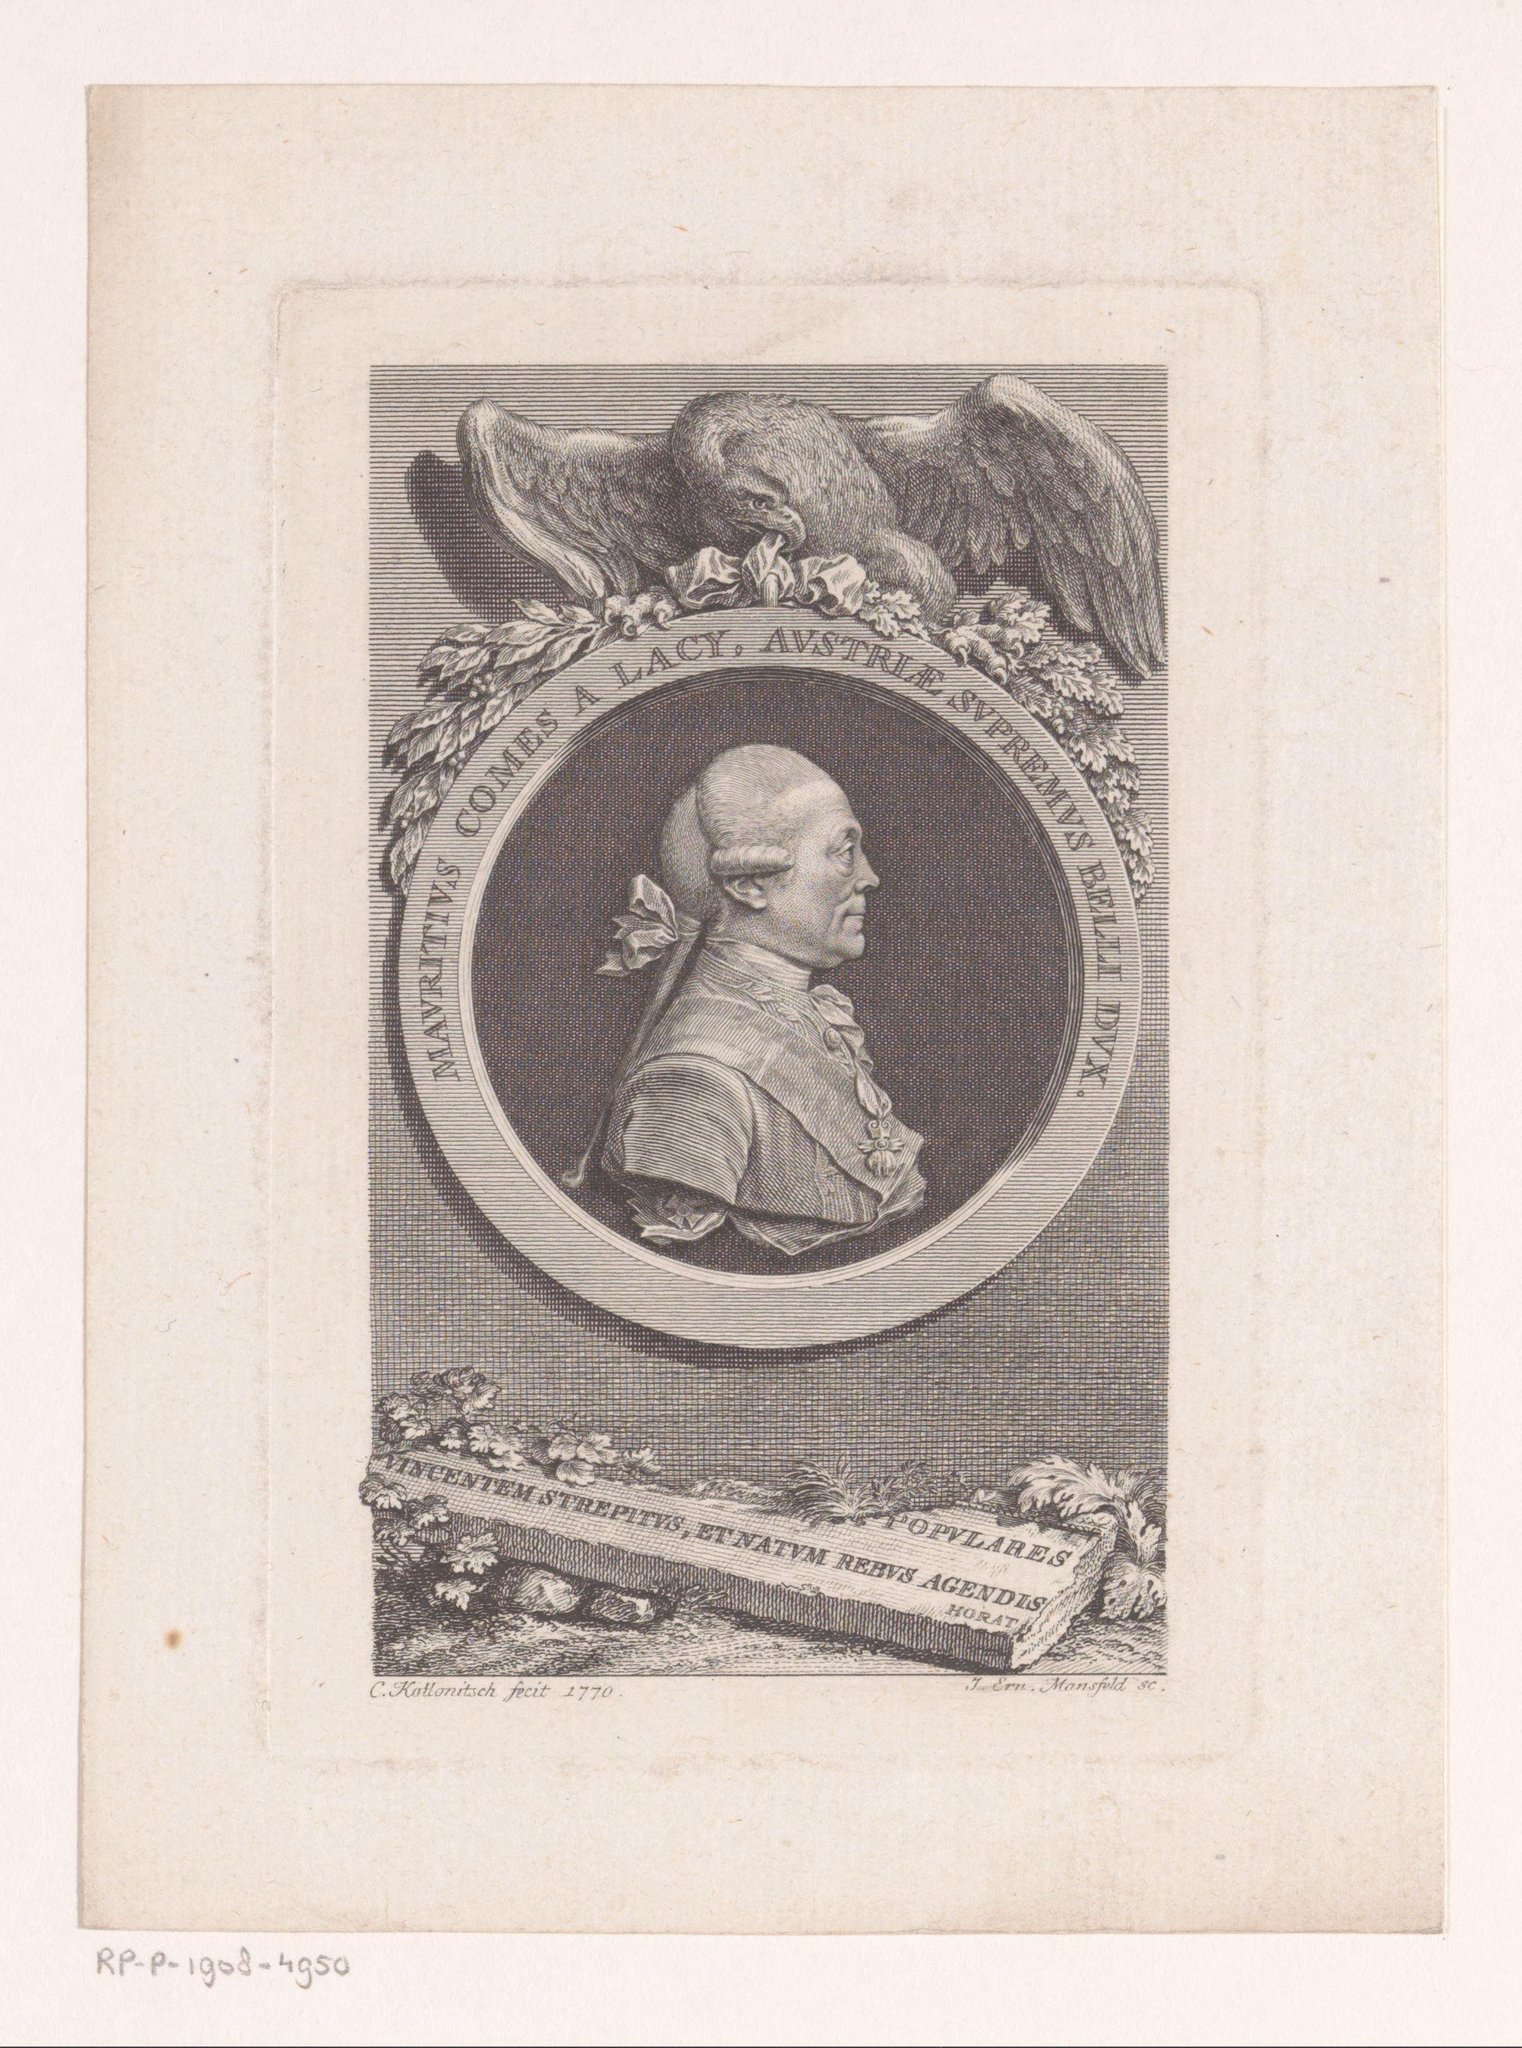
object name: print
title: Portret van Joseph Franz Moritz von Lacy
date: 1770-1796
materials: paper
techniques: engraving, etching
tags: vienna, predatory birds: eagle, historical persons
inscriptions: collector's mark: Lugt 2228